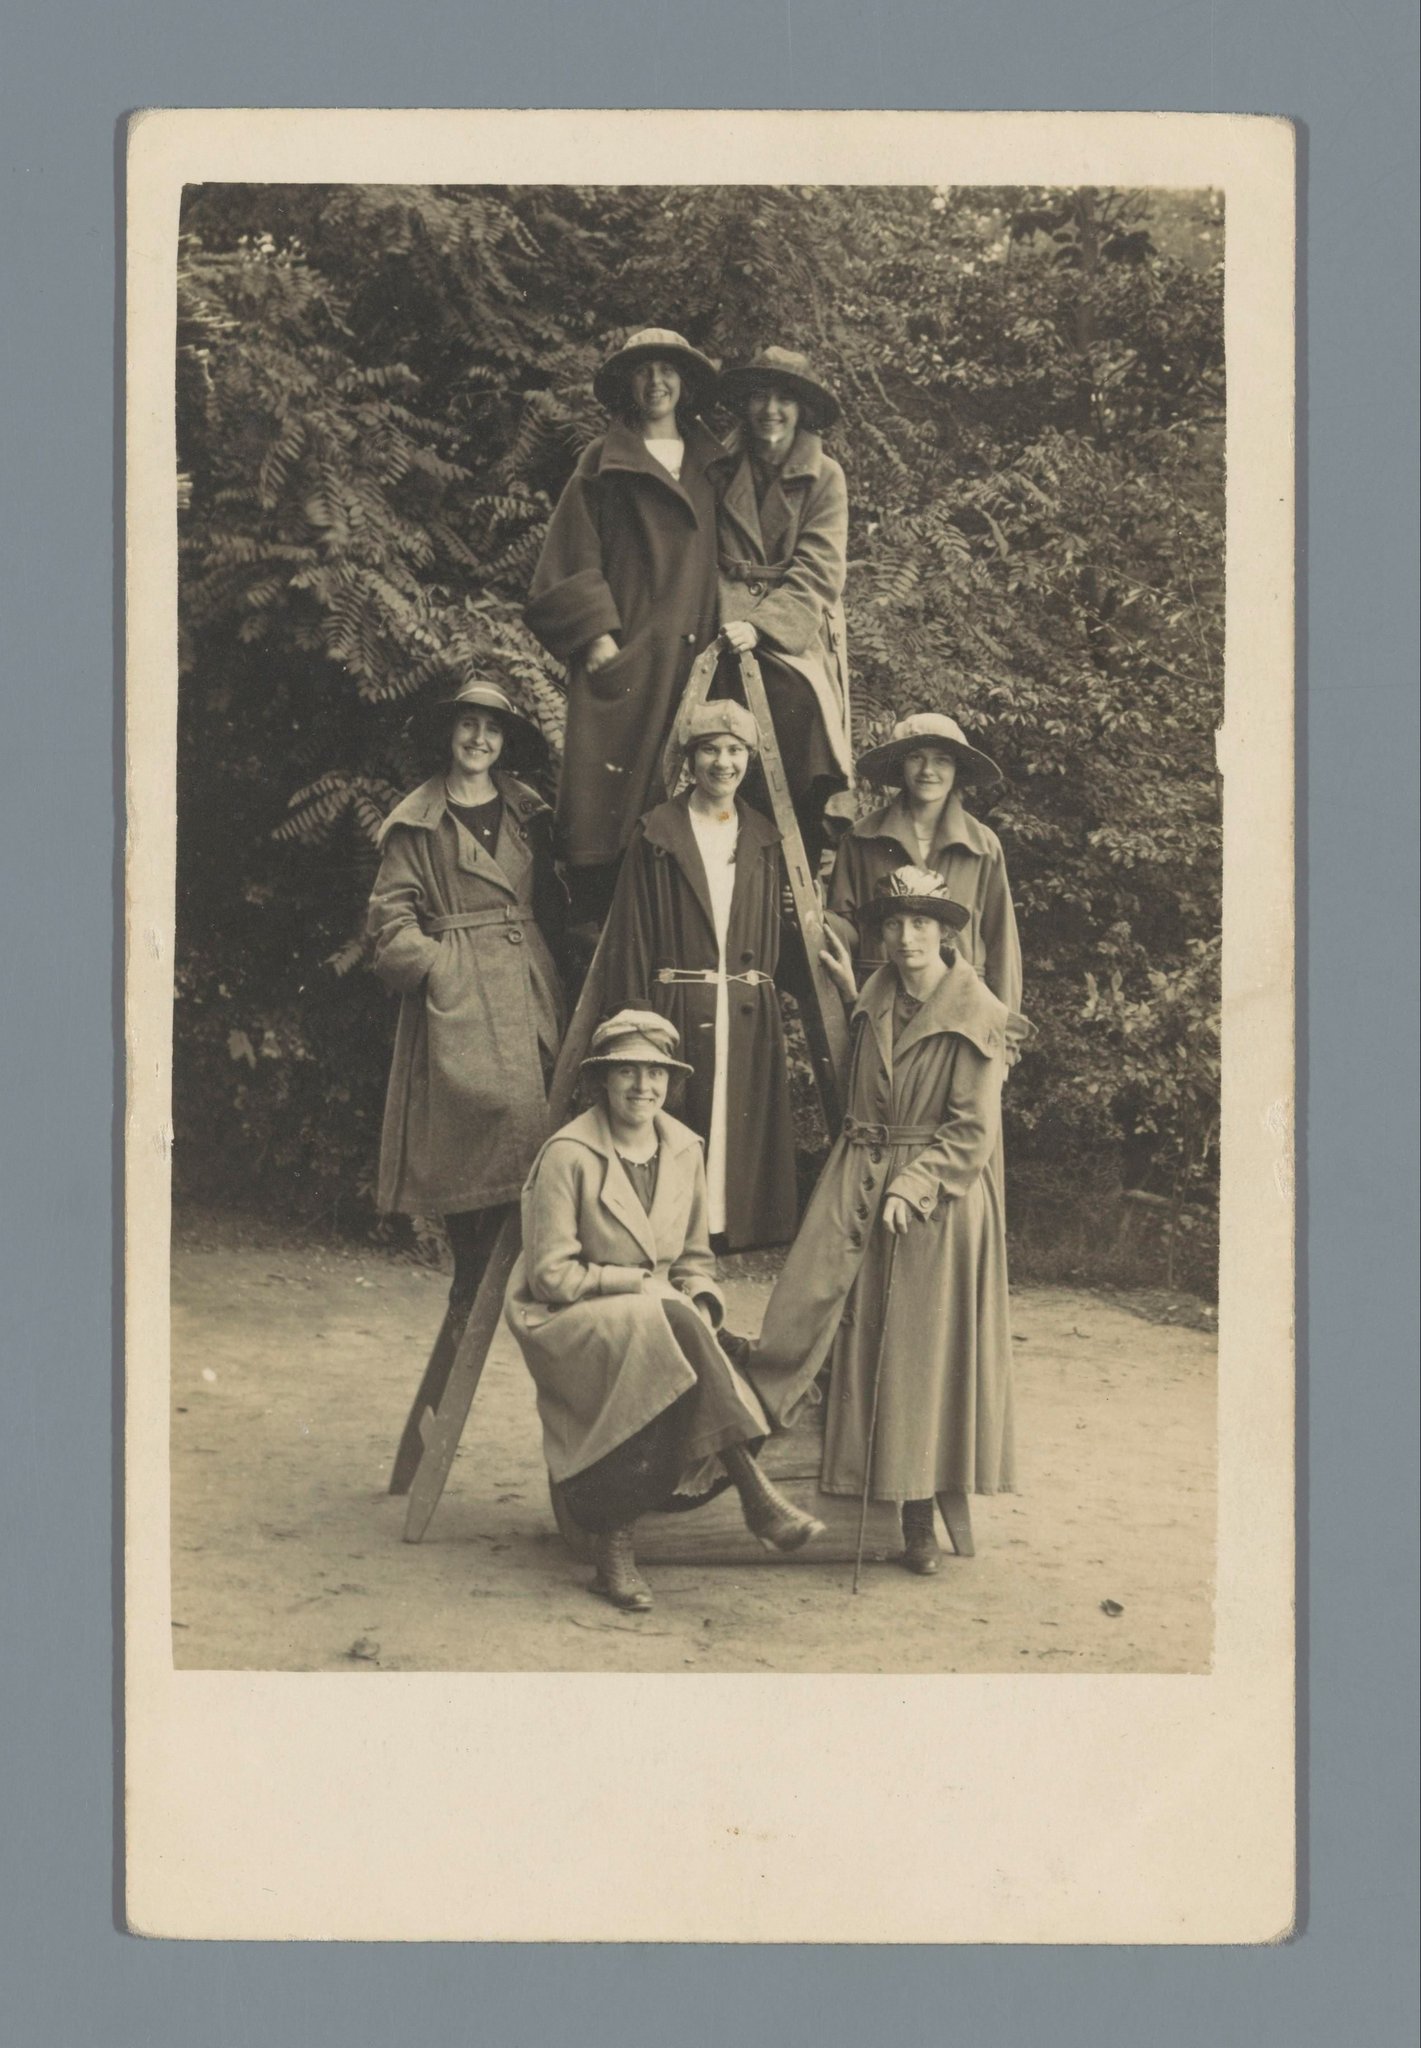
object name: photograph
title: Groepsportret van negen onbekende vrouwen op een ladder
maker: Anonymous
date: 1909-1922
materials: photographic support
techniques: gelatin silver print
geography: netherlands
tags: adult woman, ladder, anonymous historical persons portrayed in a group, in a group-portrait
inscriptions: date: ‘sept: 1922’